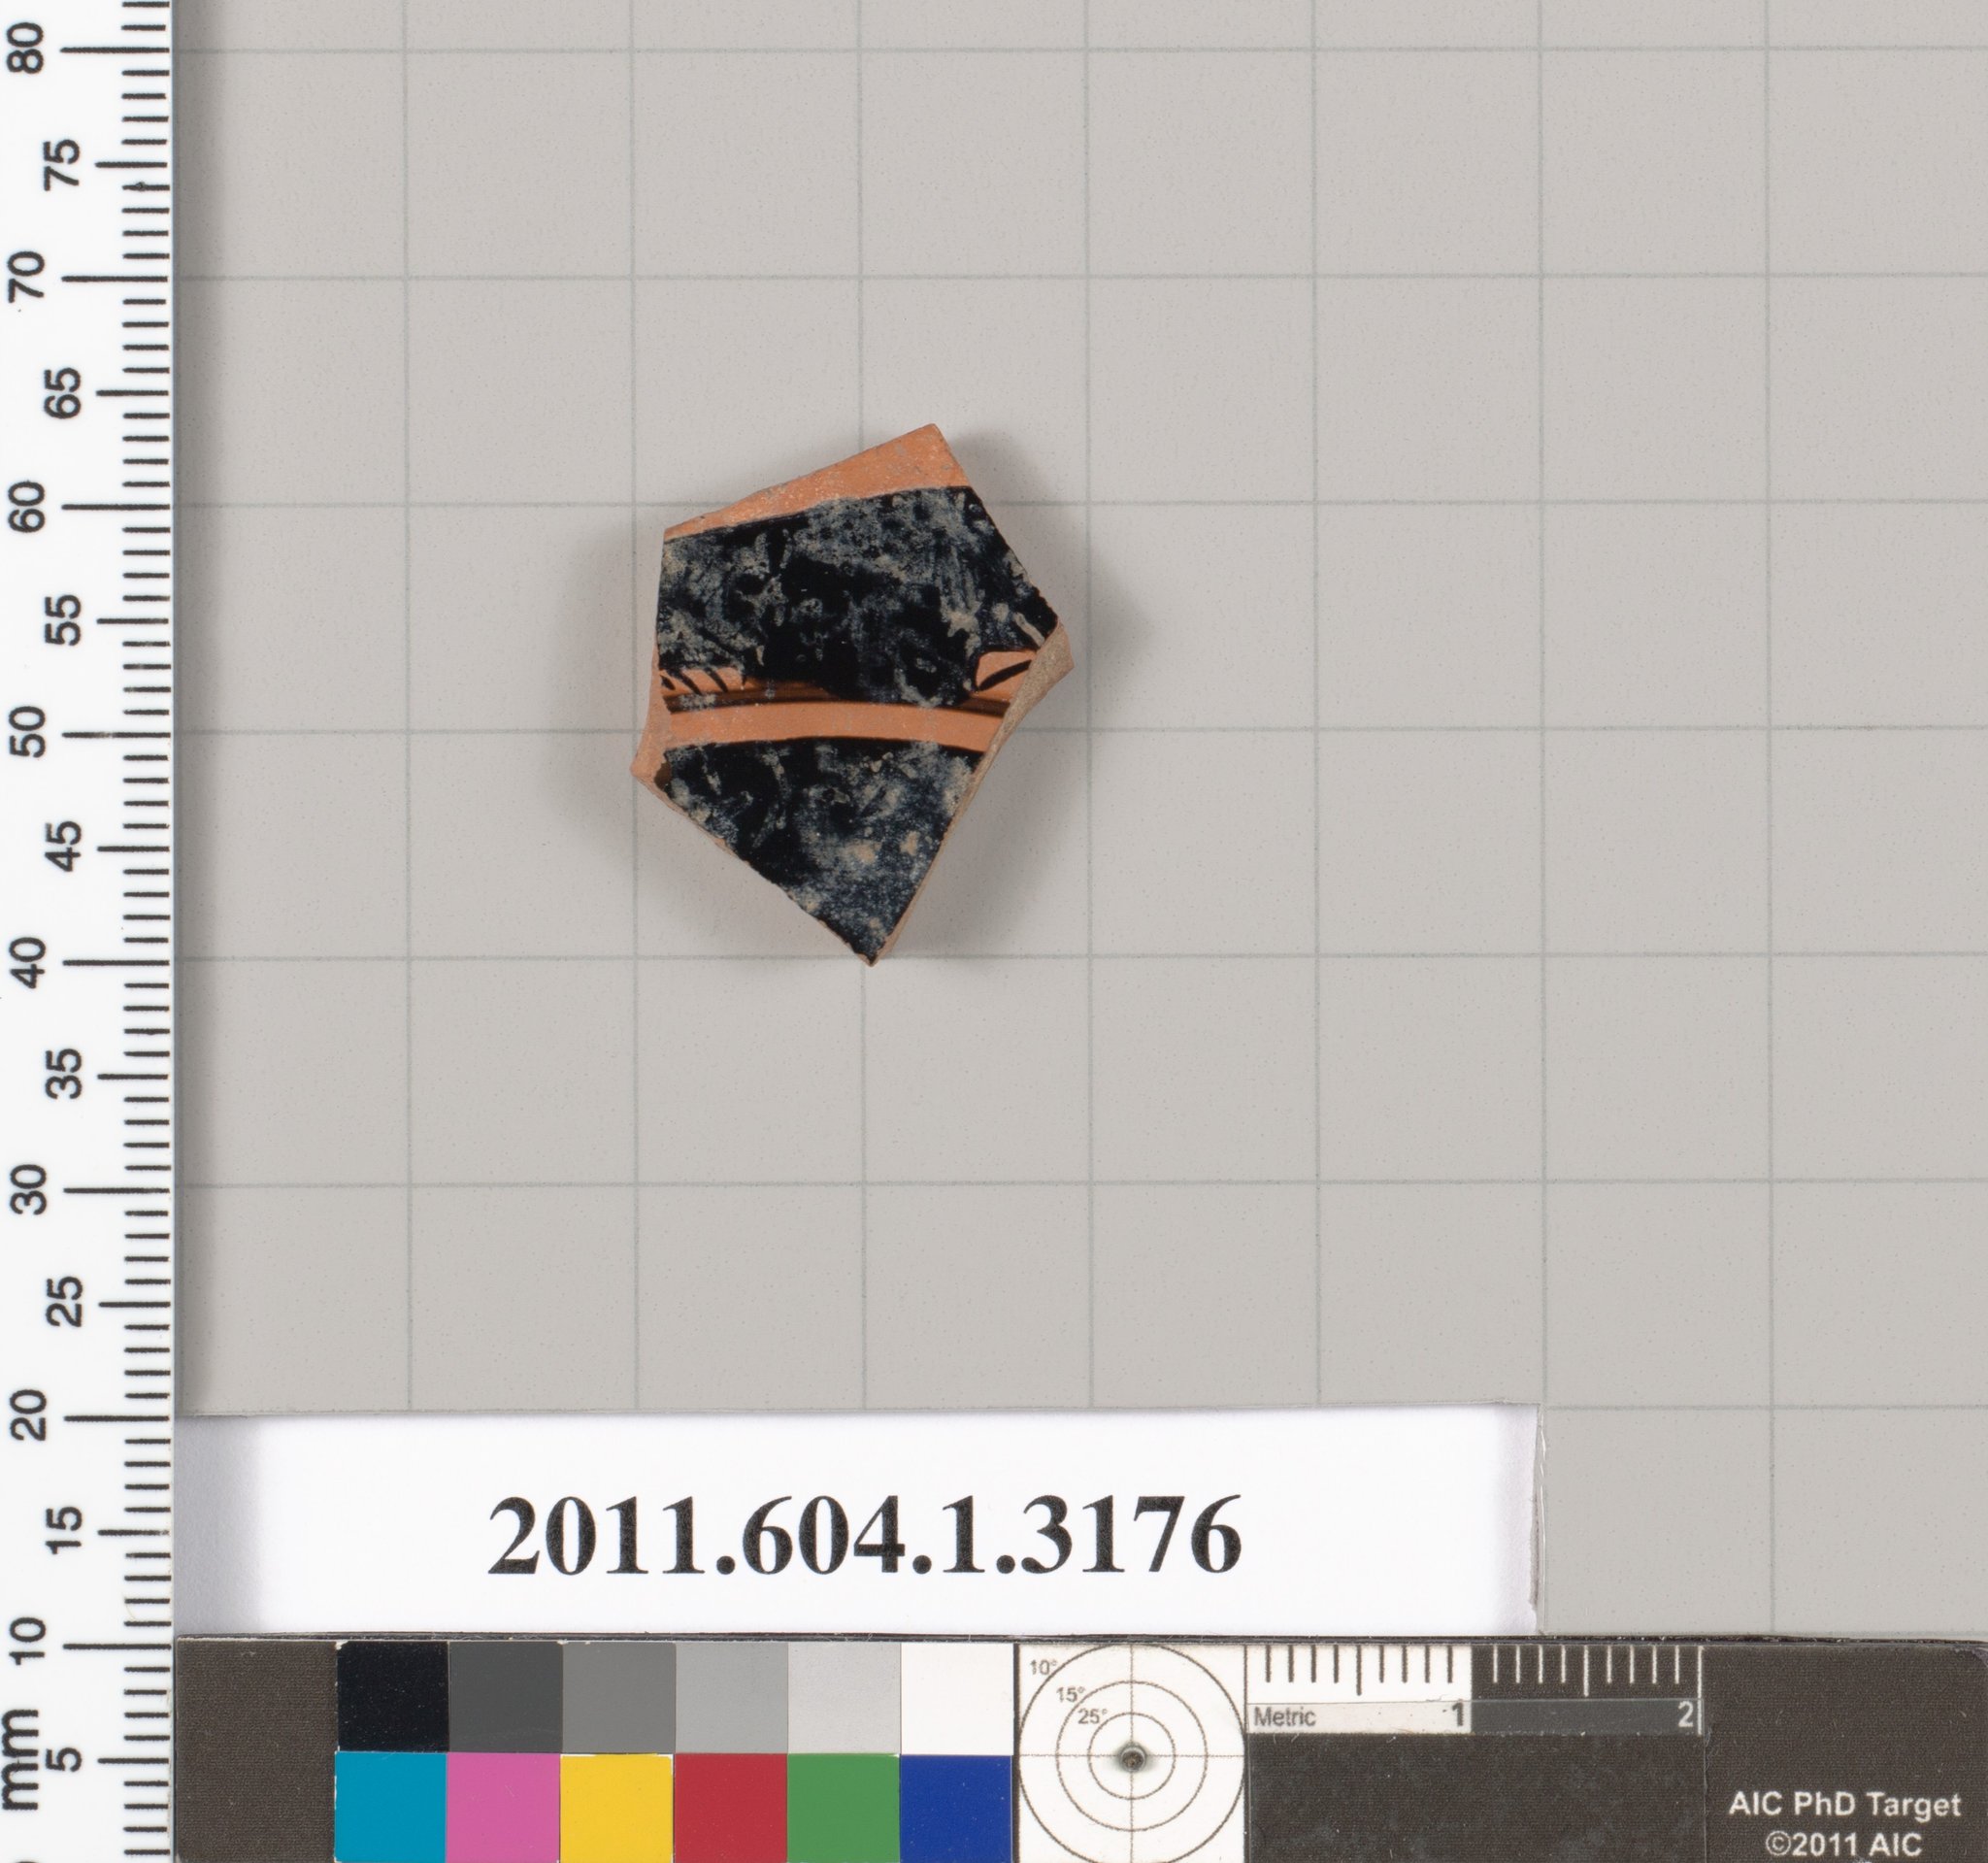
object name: kylix fragment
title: Terracotta fragment of a kylix (drinking cup)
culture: greek, attic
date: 500-490 BCE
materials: terracotta